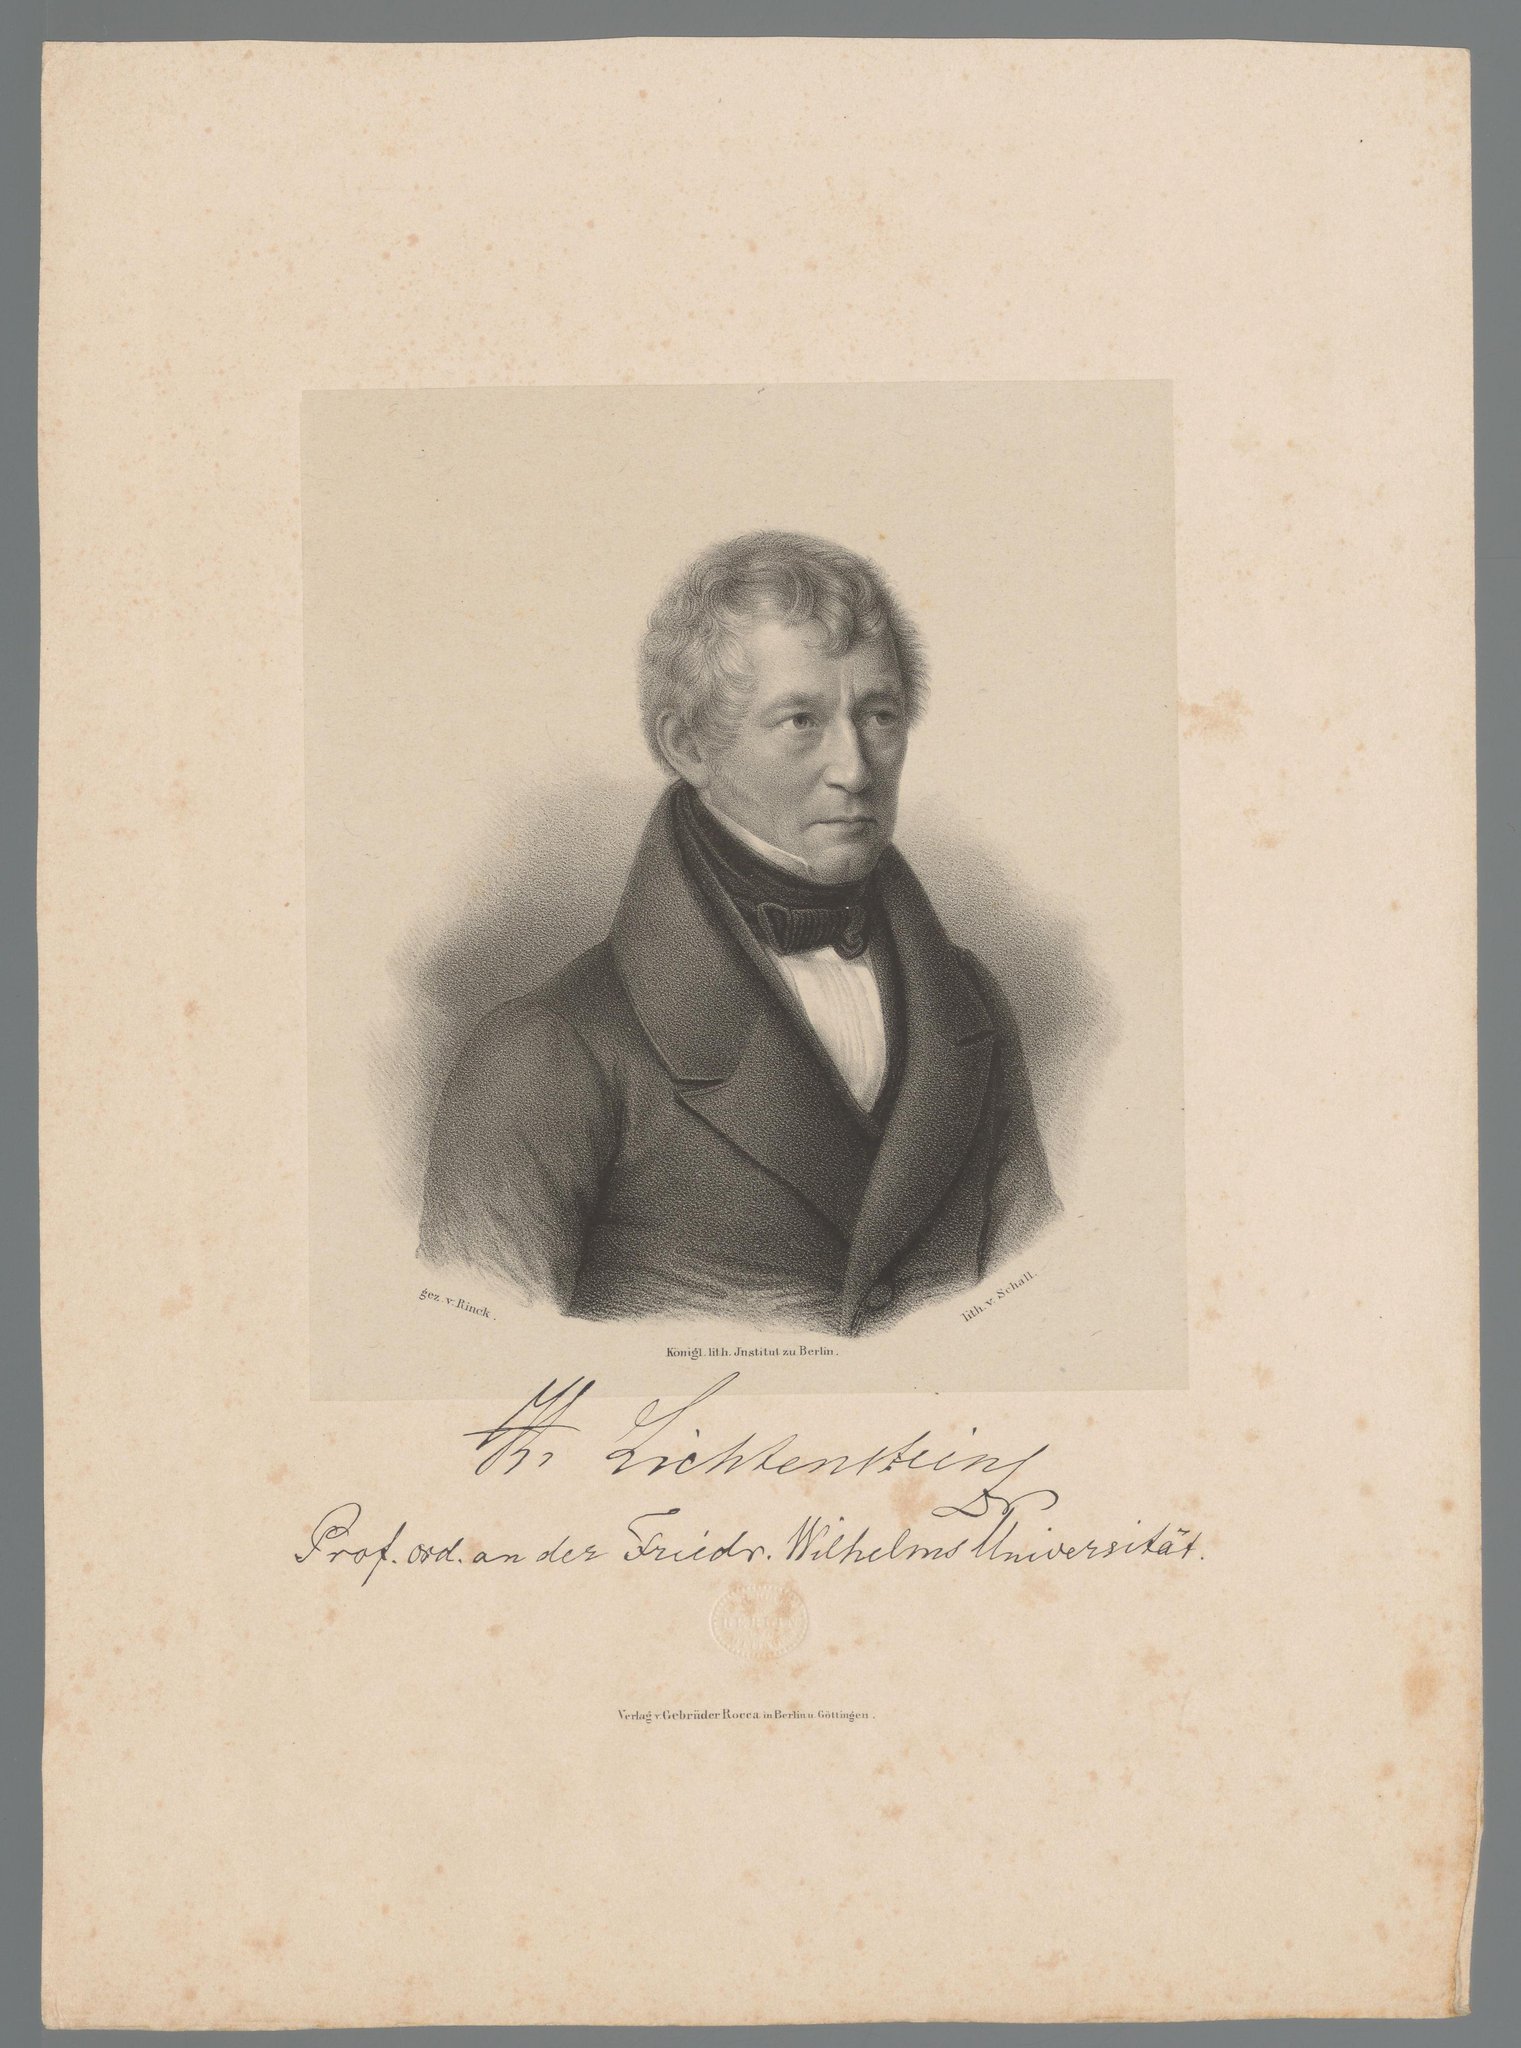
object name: print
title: Portret van Martin Hinrich Lichtenstein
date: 1820-1865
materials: paper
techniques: lithograph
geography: berlin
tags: adult man, historical persons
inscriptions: collector's mark: Lugt 2228, check stamp: Lugt 5514